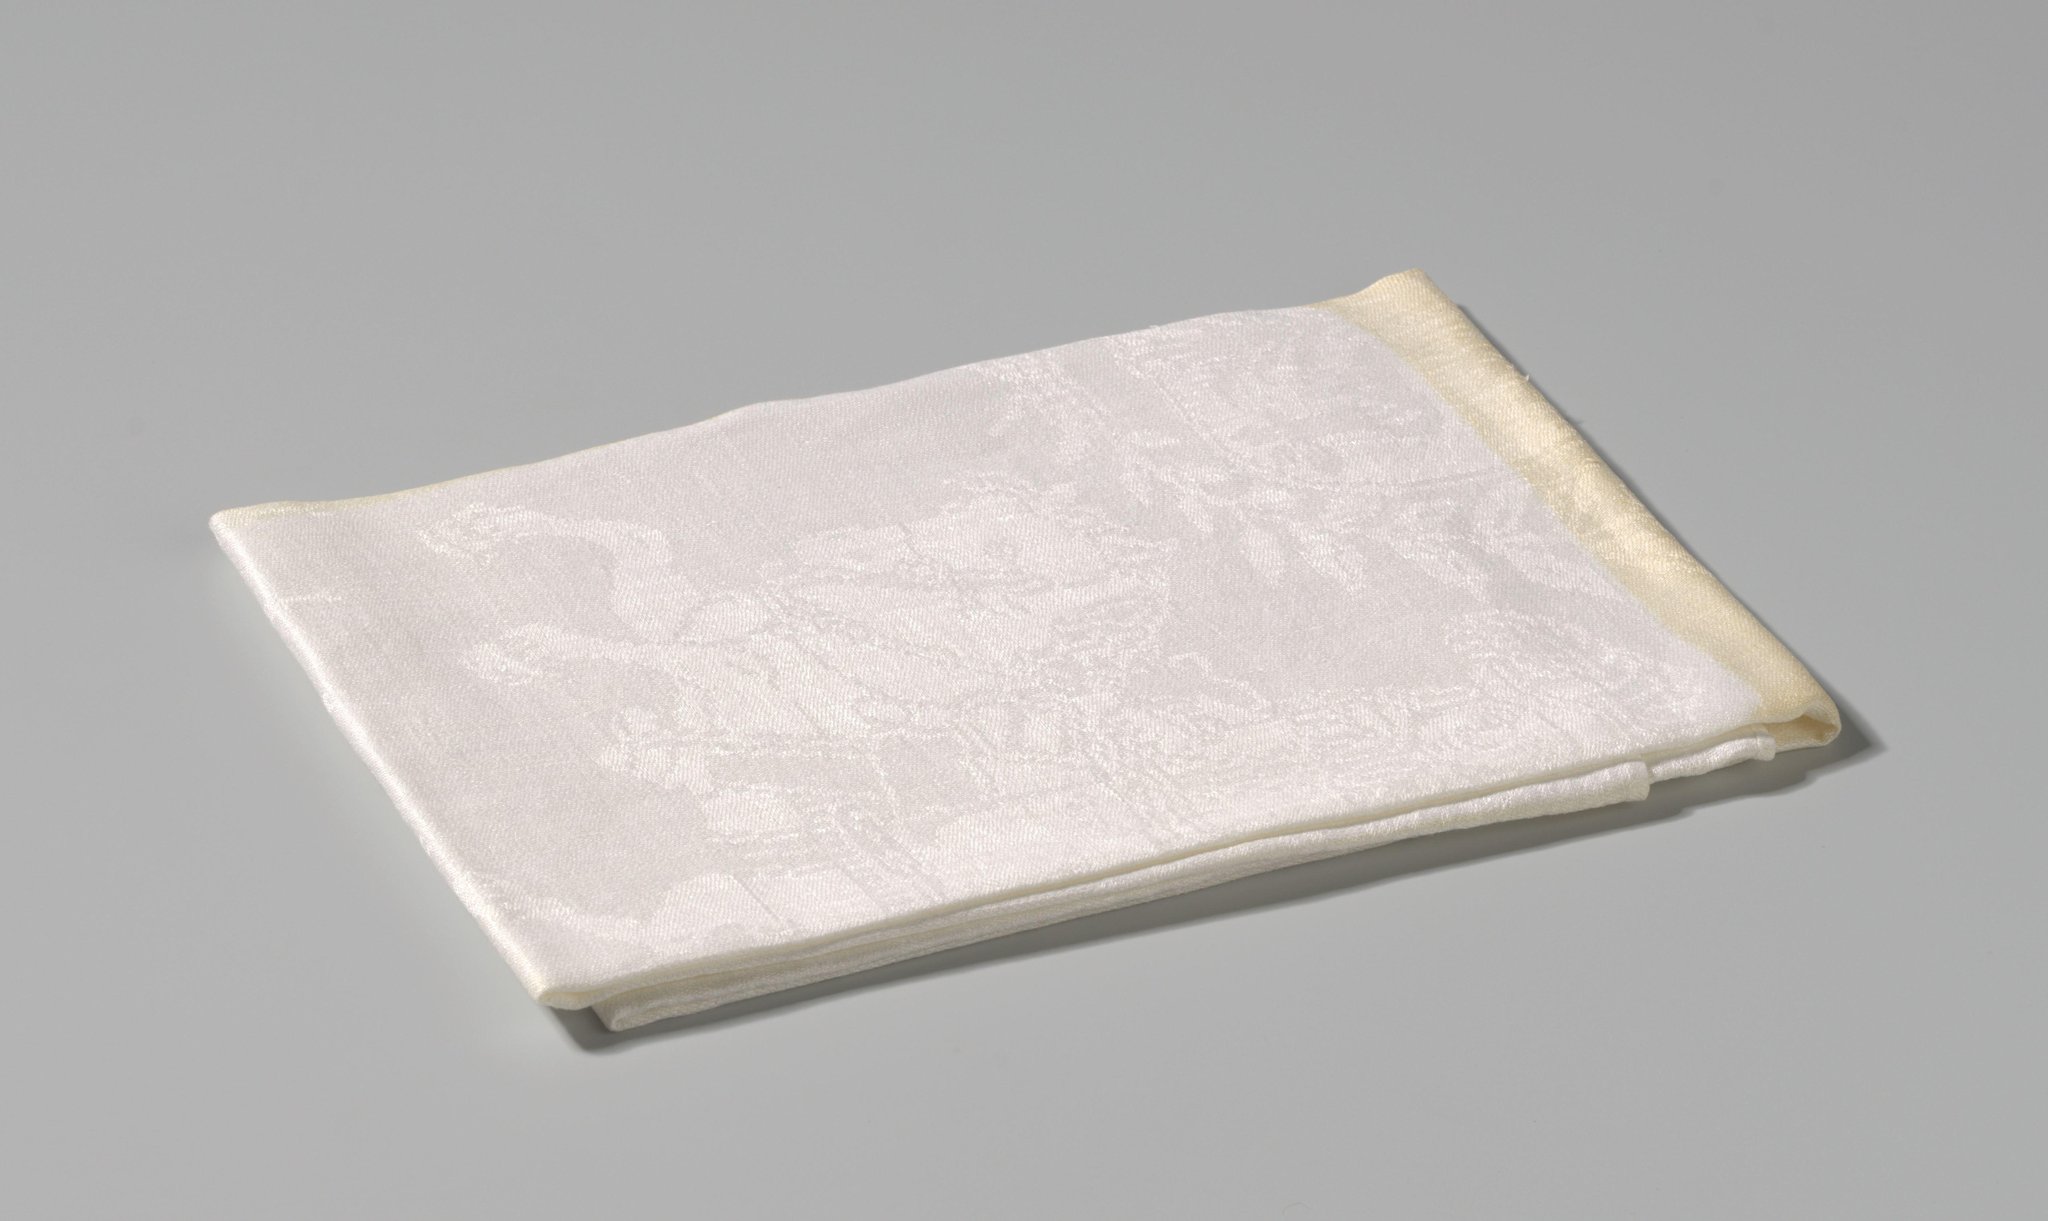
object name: napkin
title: Servet met de verovering van Neuhäusel, Gran, Buda en Pest door Leopold I, keizer van Duitsland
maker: Anonymous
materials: linen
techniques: damask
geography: flanders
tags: leopold i (keizer van duitsland)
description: Servet van linnendamast met de verovering van Neuhäusel, Gran, Buda en Pest door Leopold I; met het wapen van het Heilige Roomse Rijk met hartschild Oosterijk.